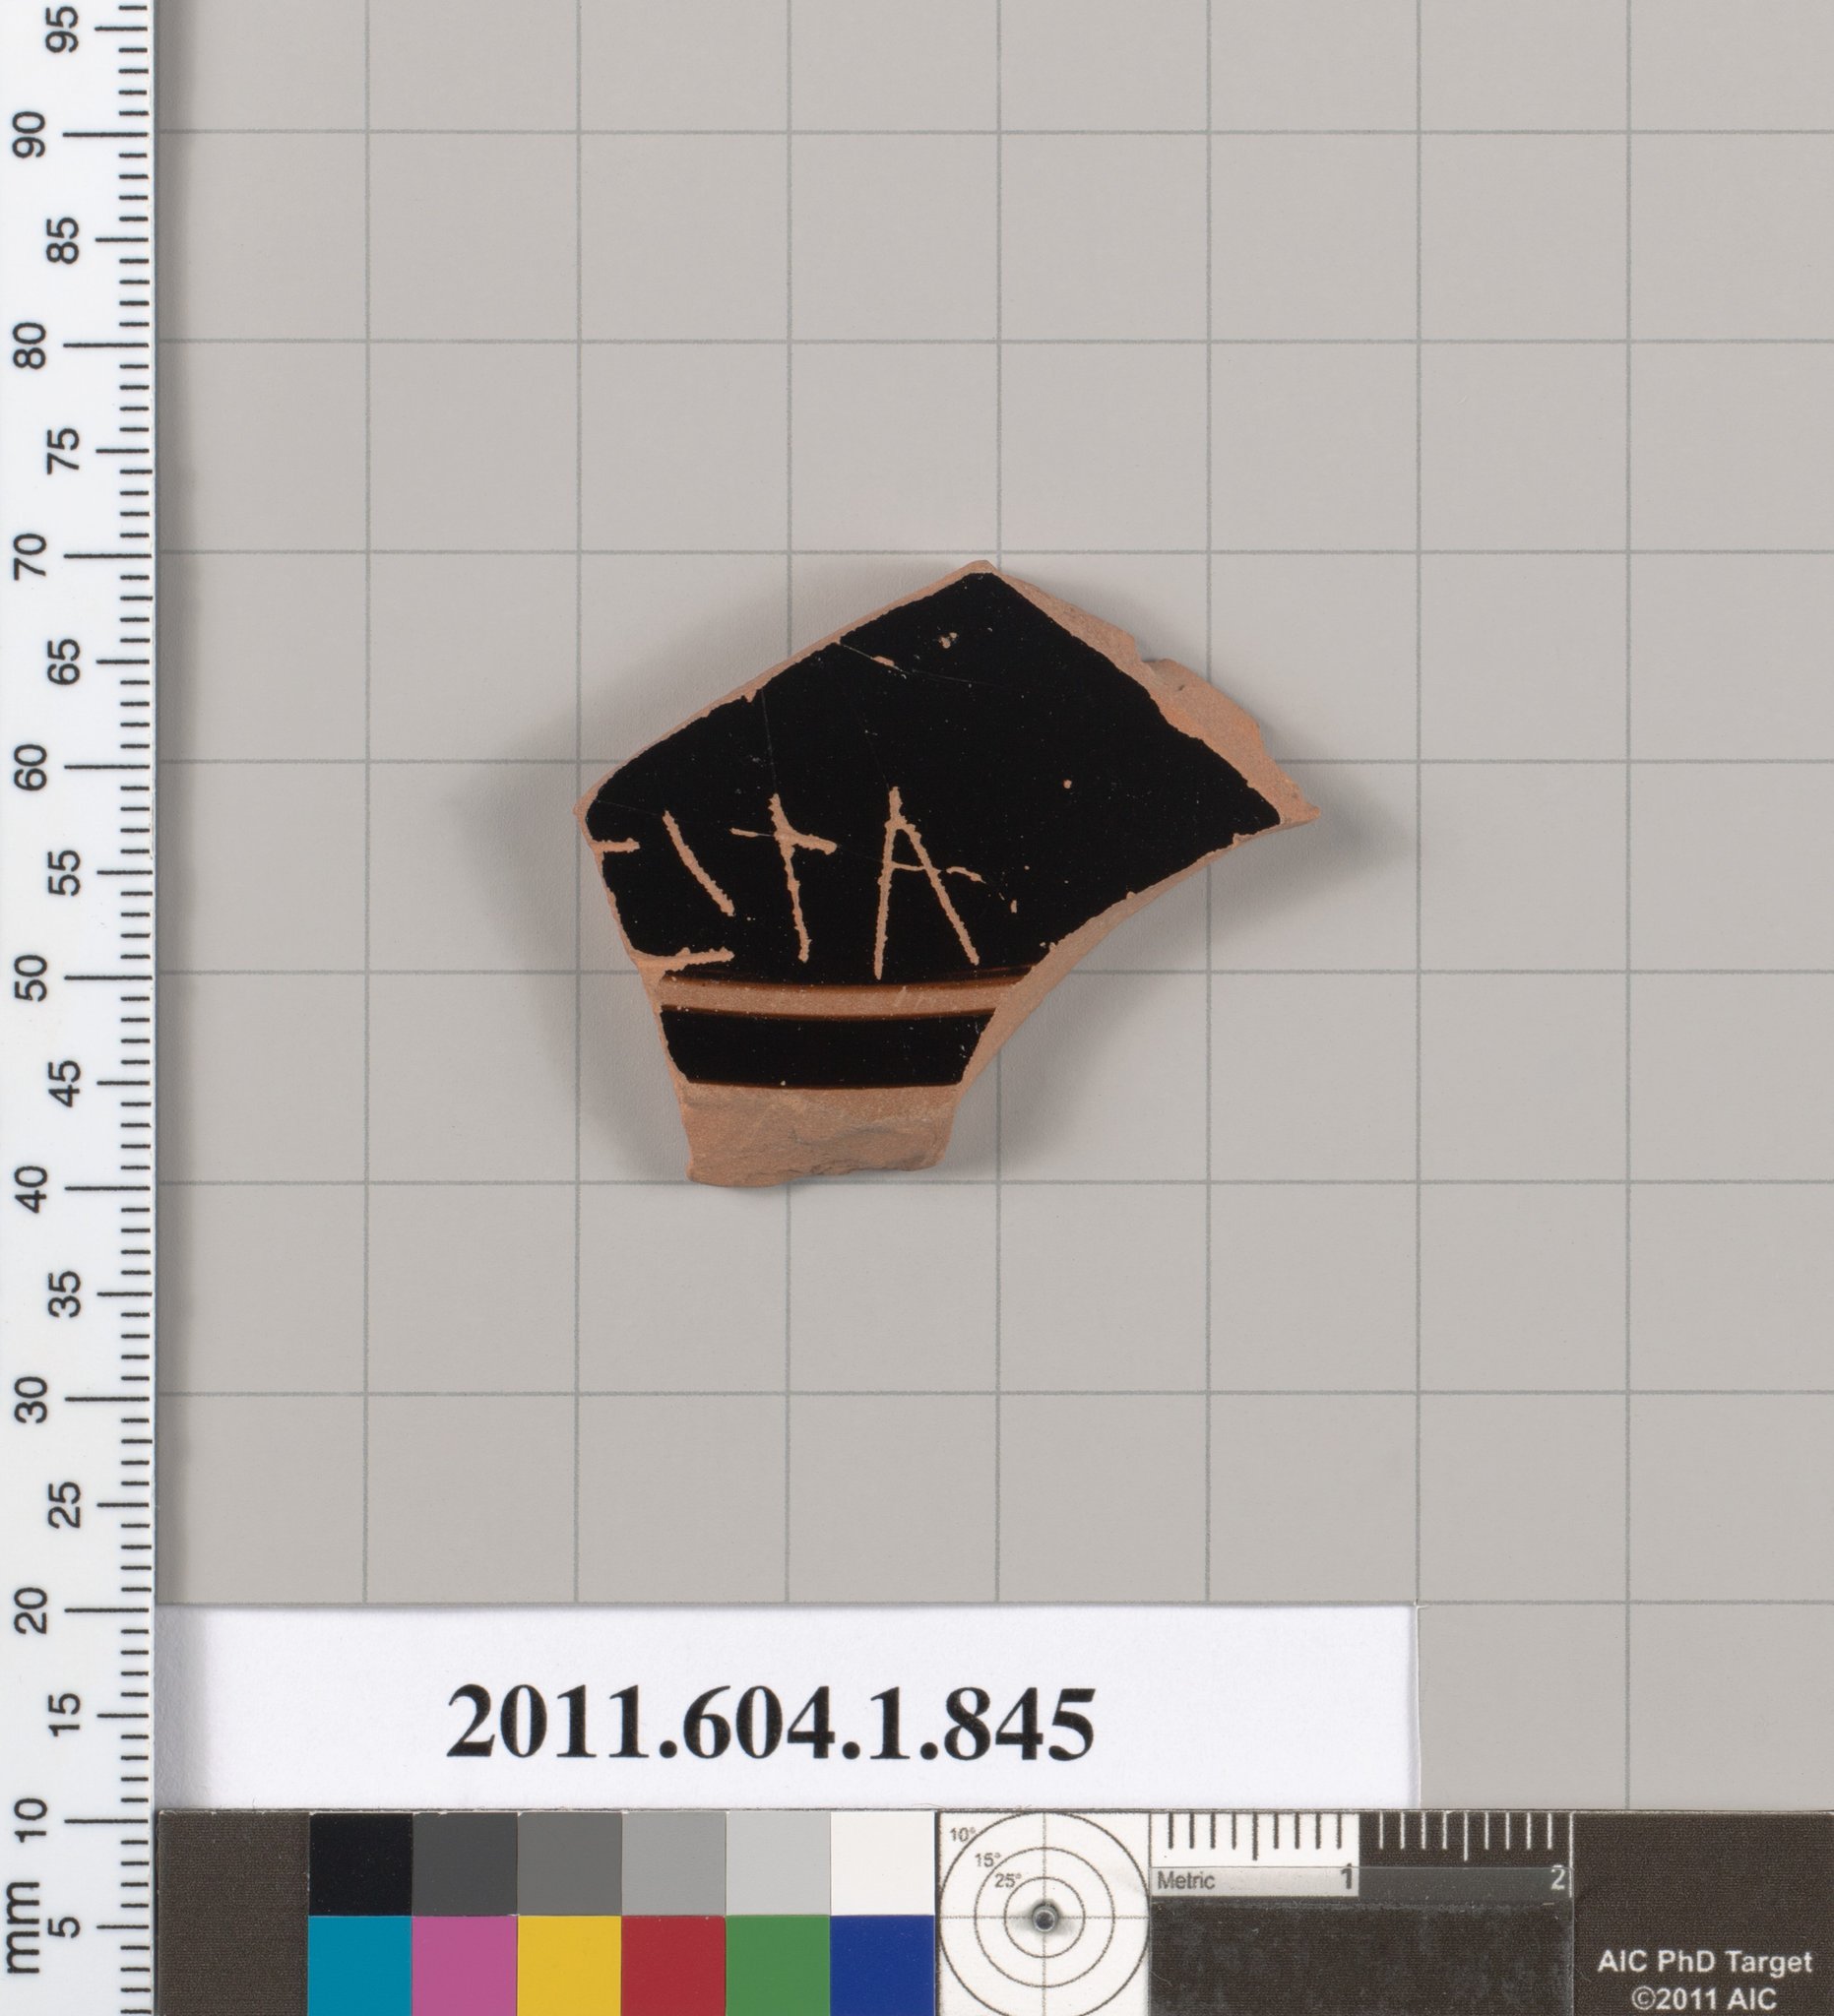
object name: kylix fragment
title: Terracotta fragment of a kylix (drinking cup)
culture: greek, attic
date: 475-451 BCE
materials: terracotta